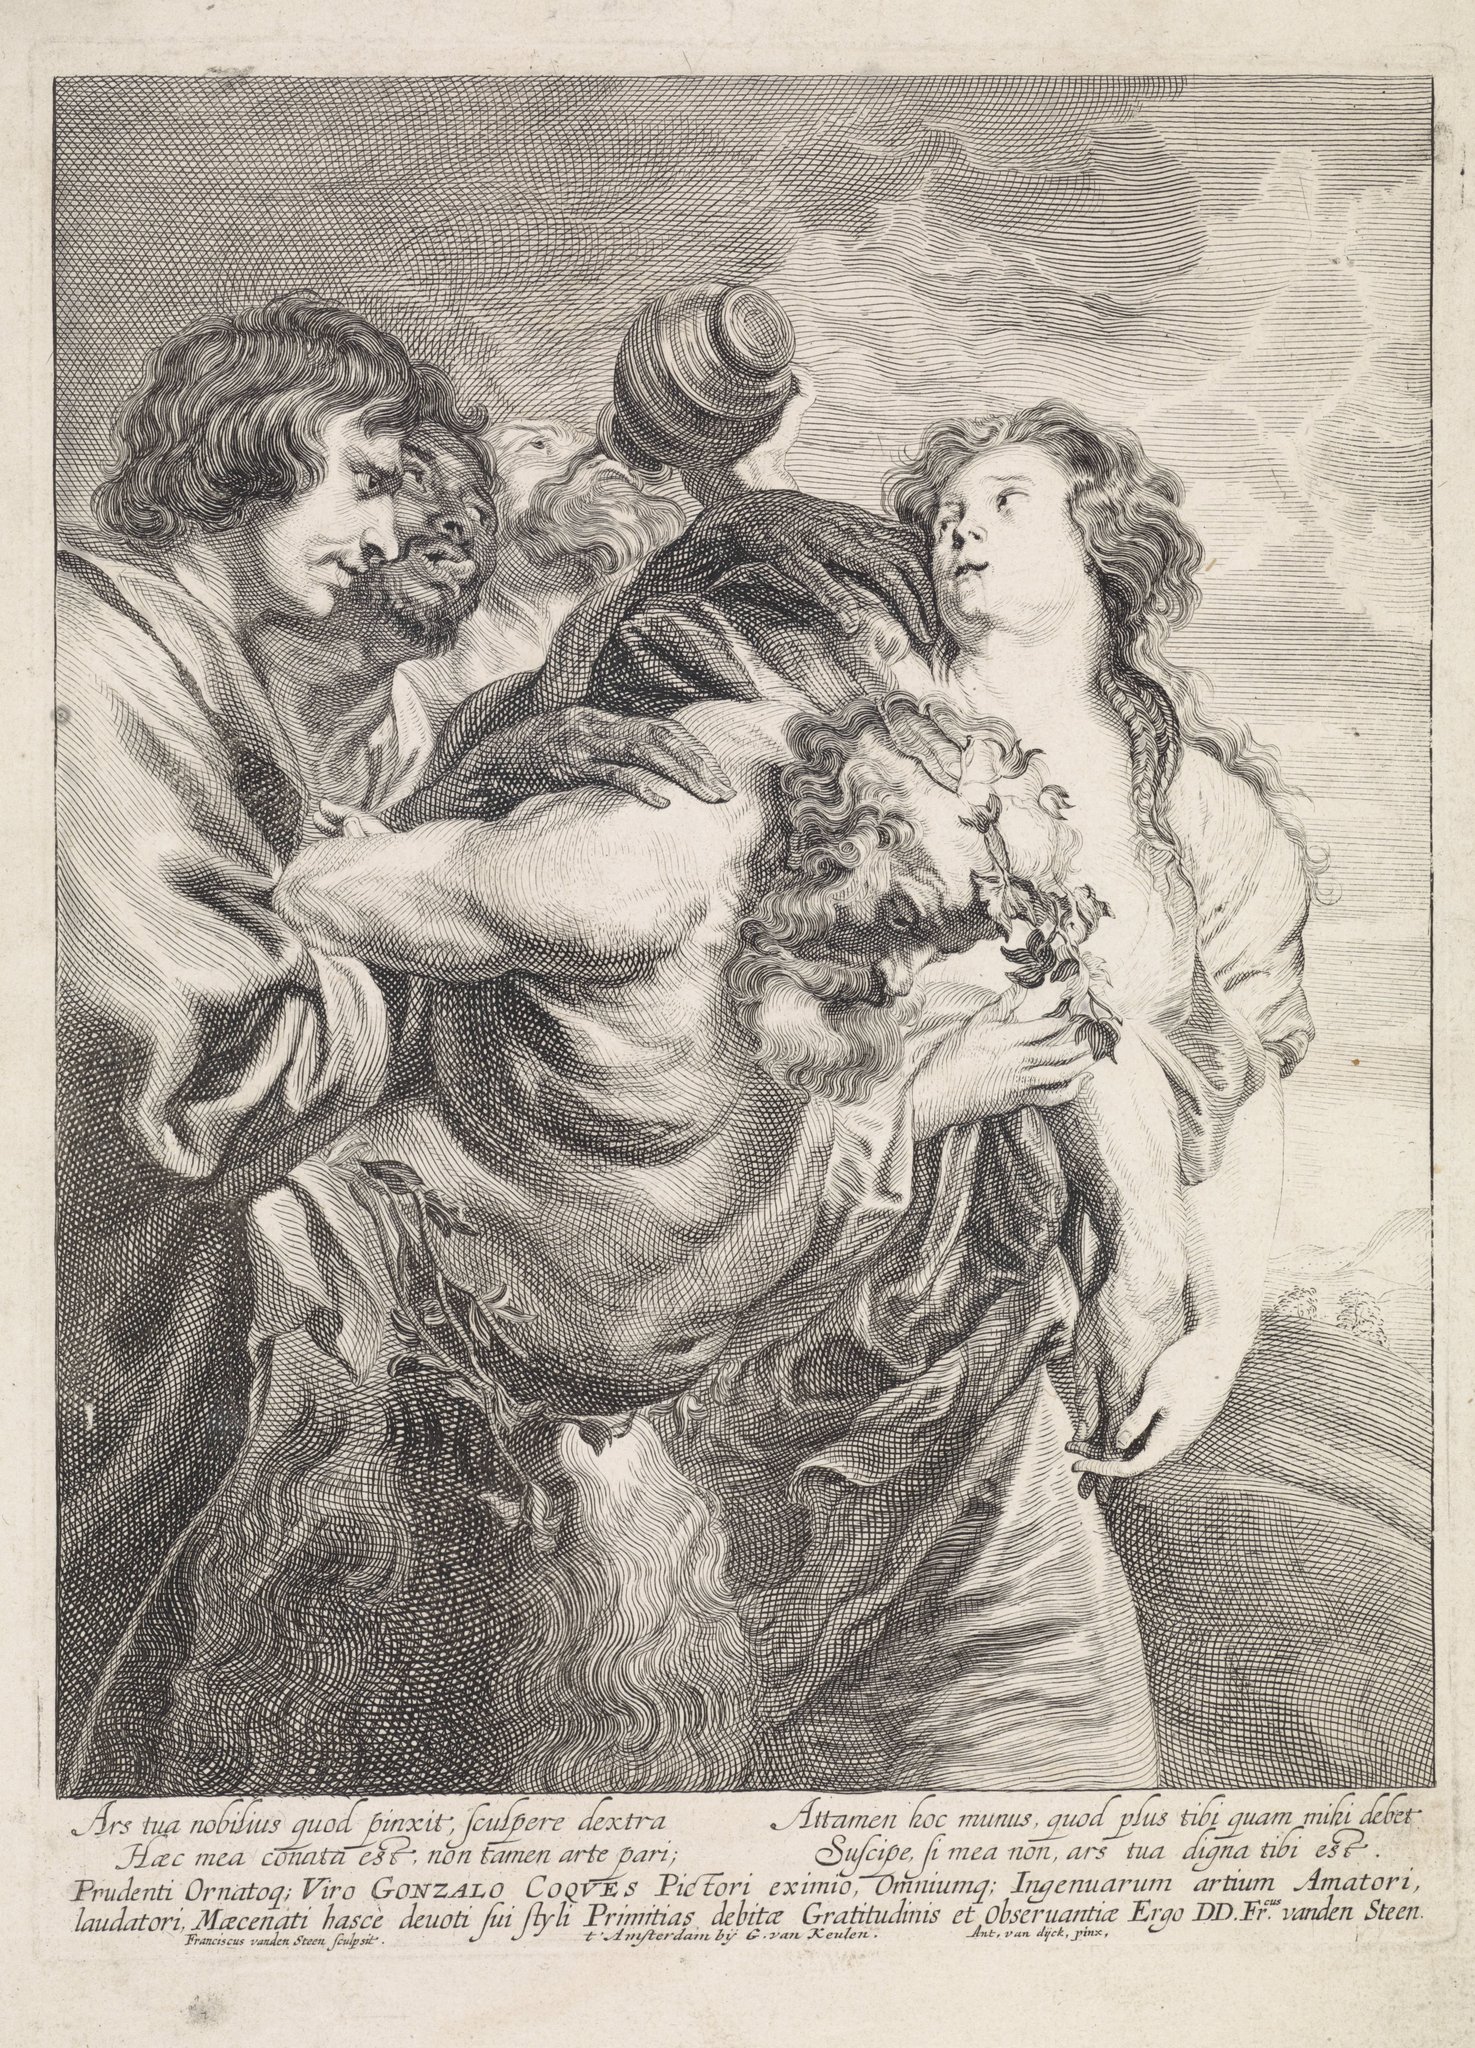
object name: print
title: Dronken Silenus ondersteund door bacchanten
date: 1643-1672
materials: paper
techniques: engraving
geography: amsterdam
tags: (story of) silenus, (story of) silenus - offspring, companion(s), train etc.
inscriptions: collector's mark: Lugt 2228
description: De dronken Silenus wordt ondersteund door bacchanten. Silenus heeft een krans van wingerdbladeren op het hoofd.